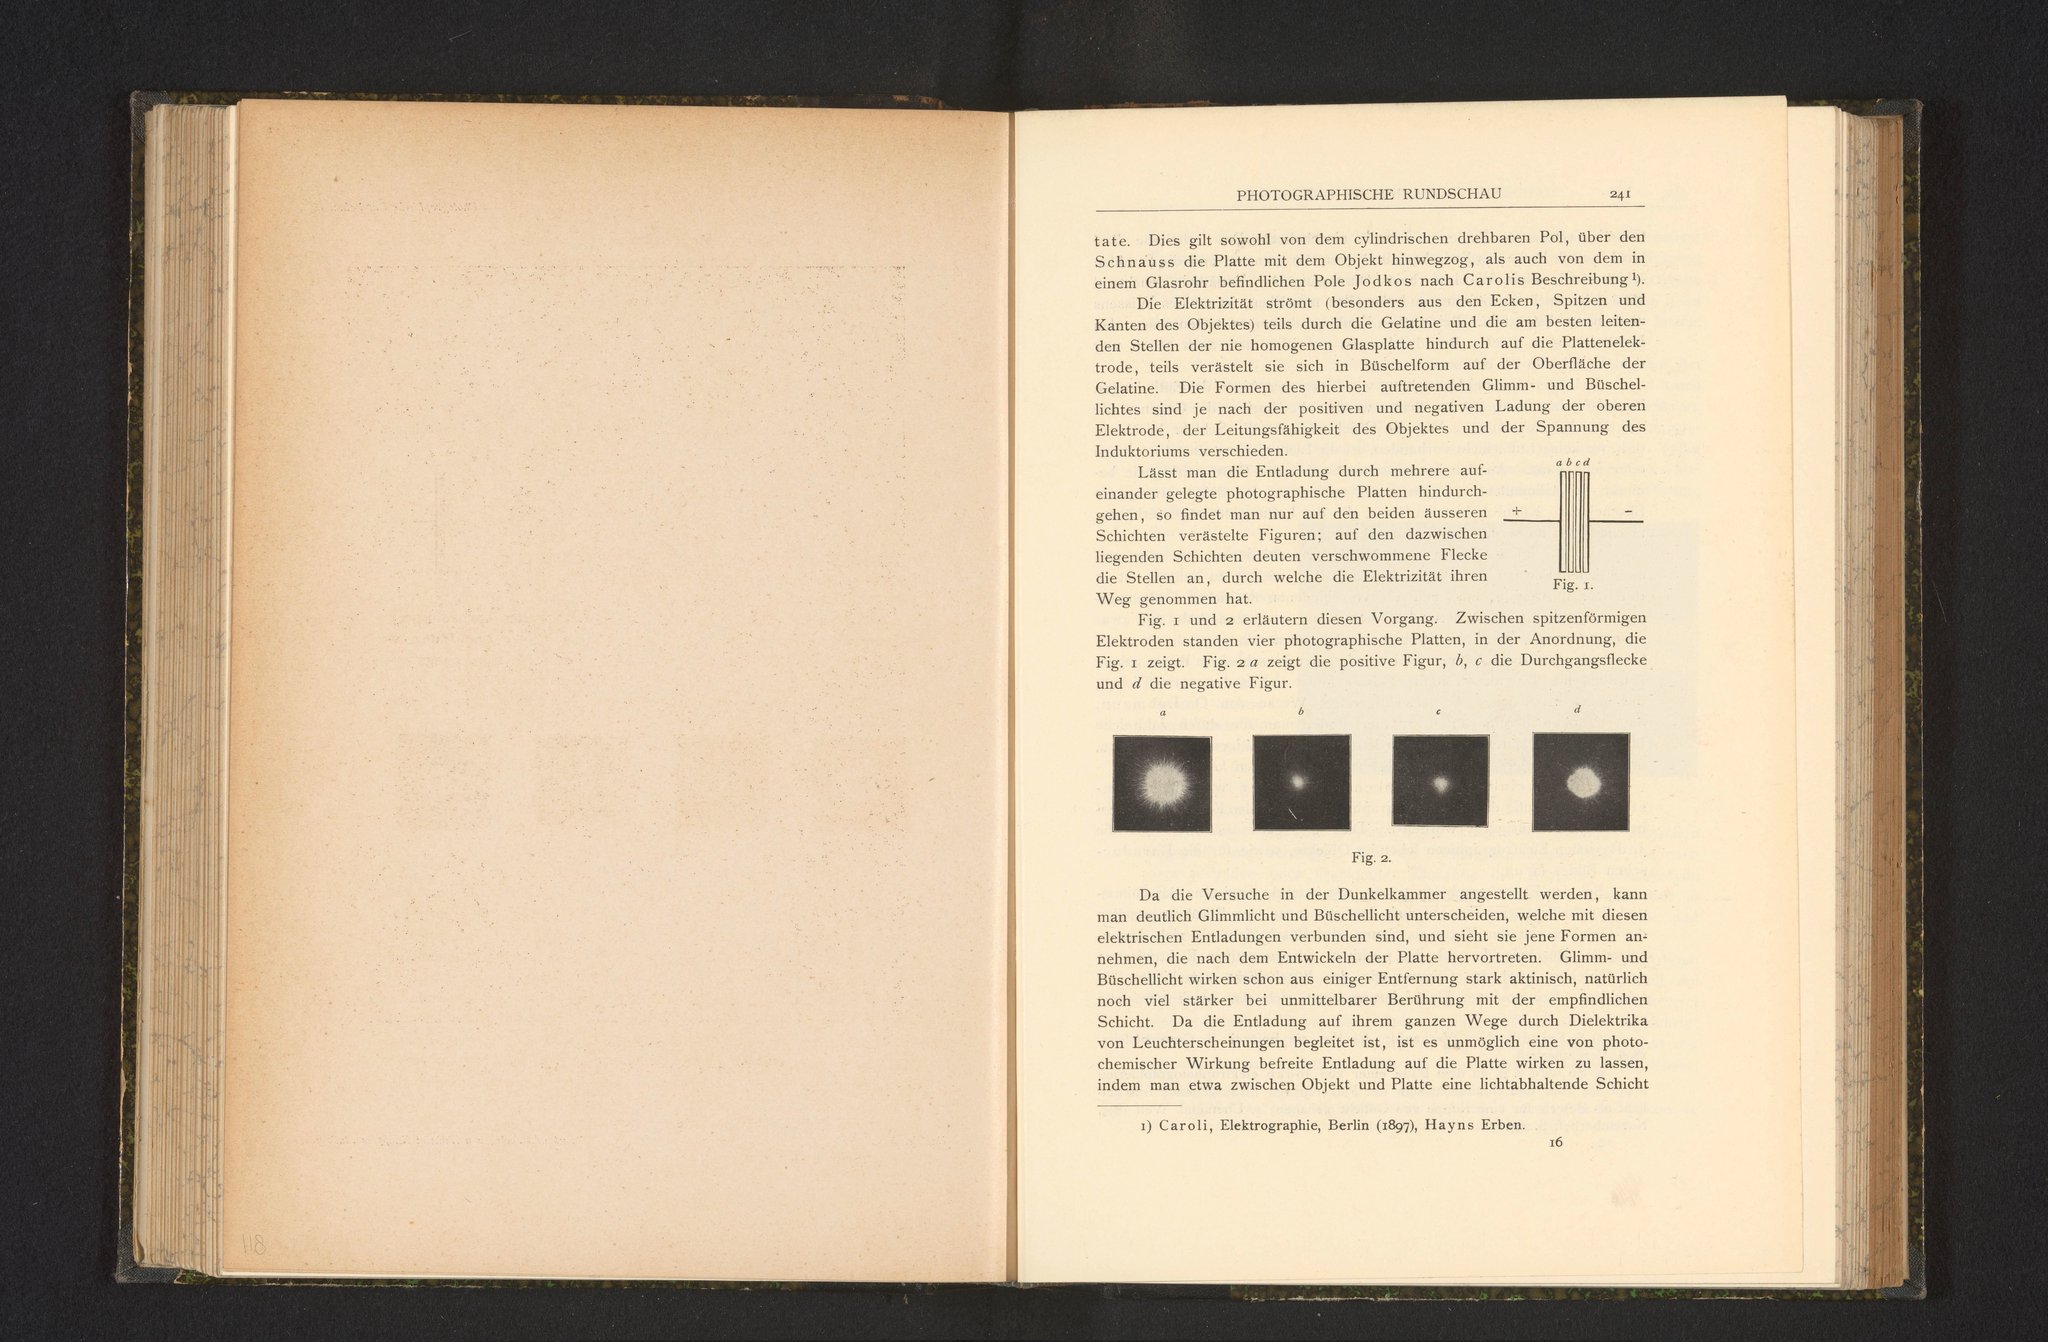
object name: page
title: Weergave van elektriciteit door vier verschillende lagen tijdens het proces van het maken van een elektrografie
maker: Anonymous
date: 1893-1898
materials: paper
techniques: autotype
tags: electrical phenomena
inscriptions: inscription: ‘a, b, c, d’